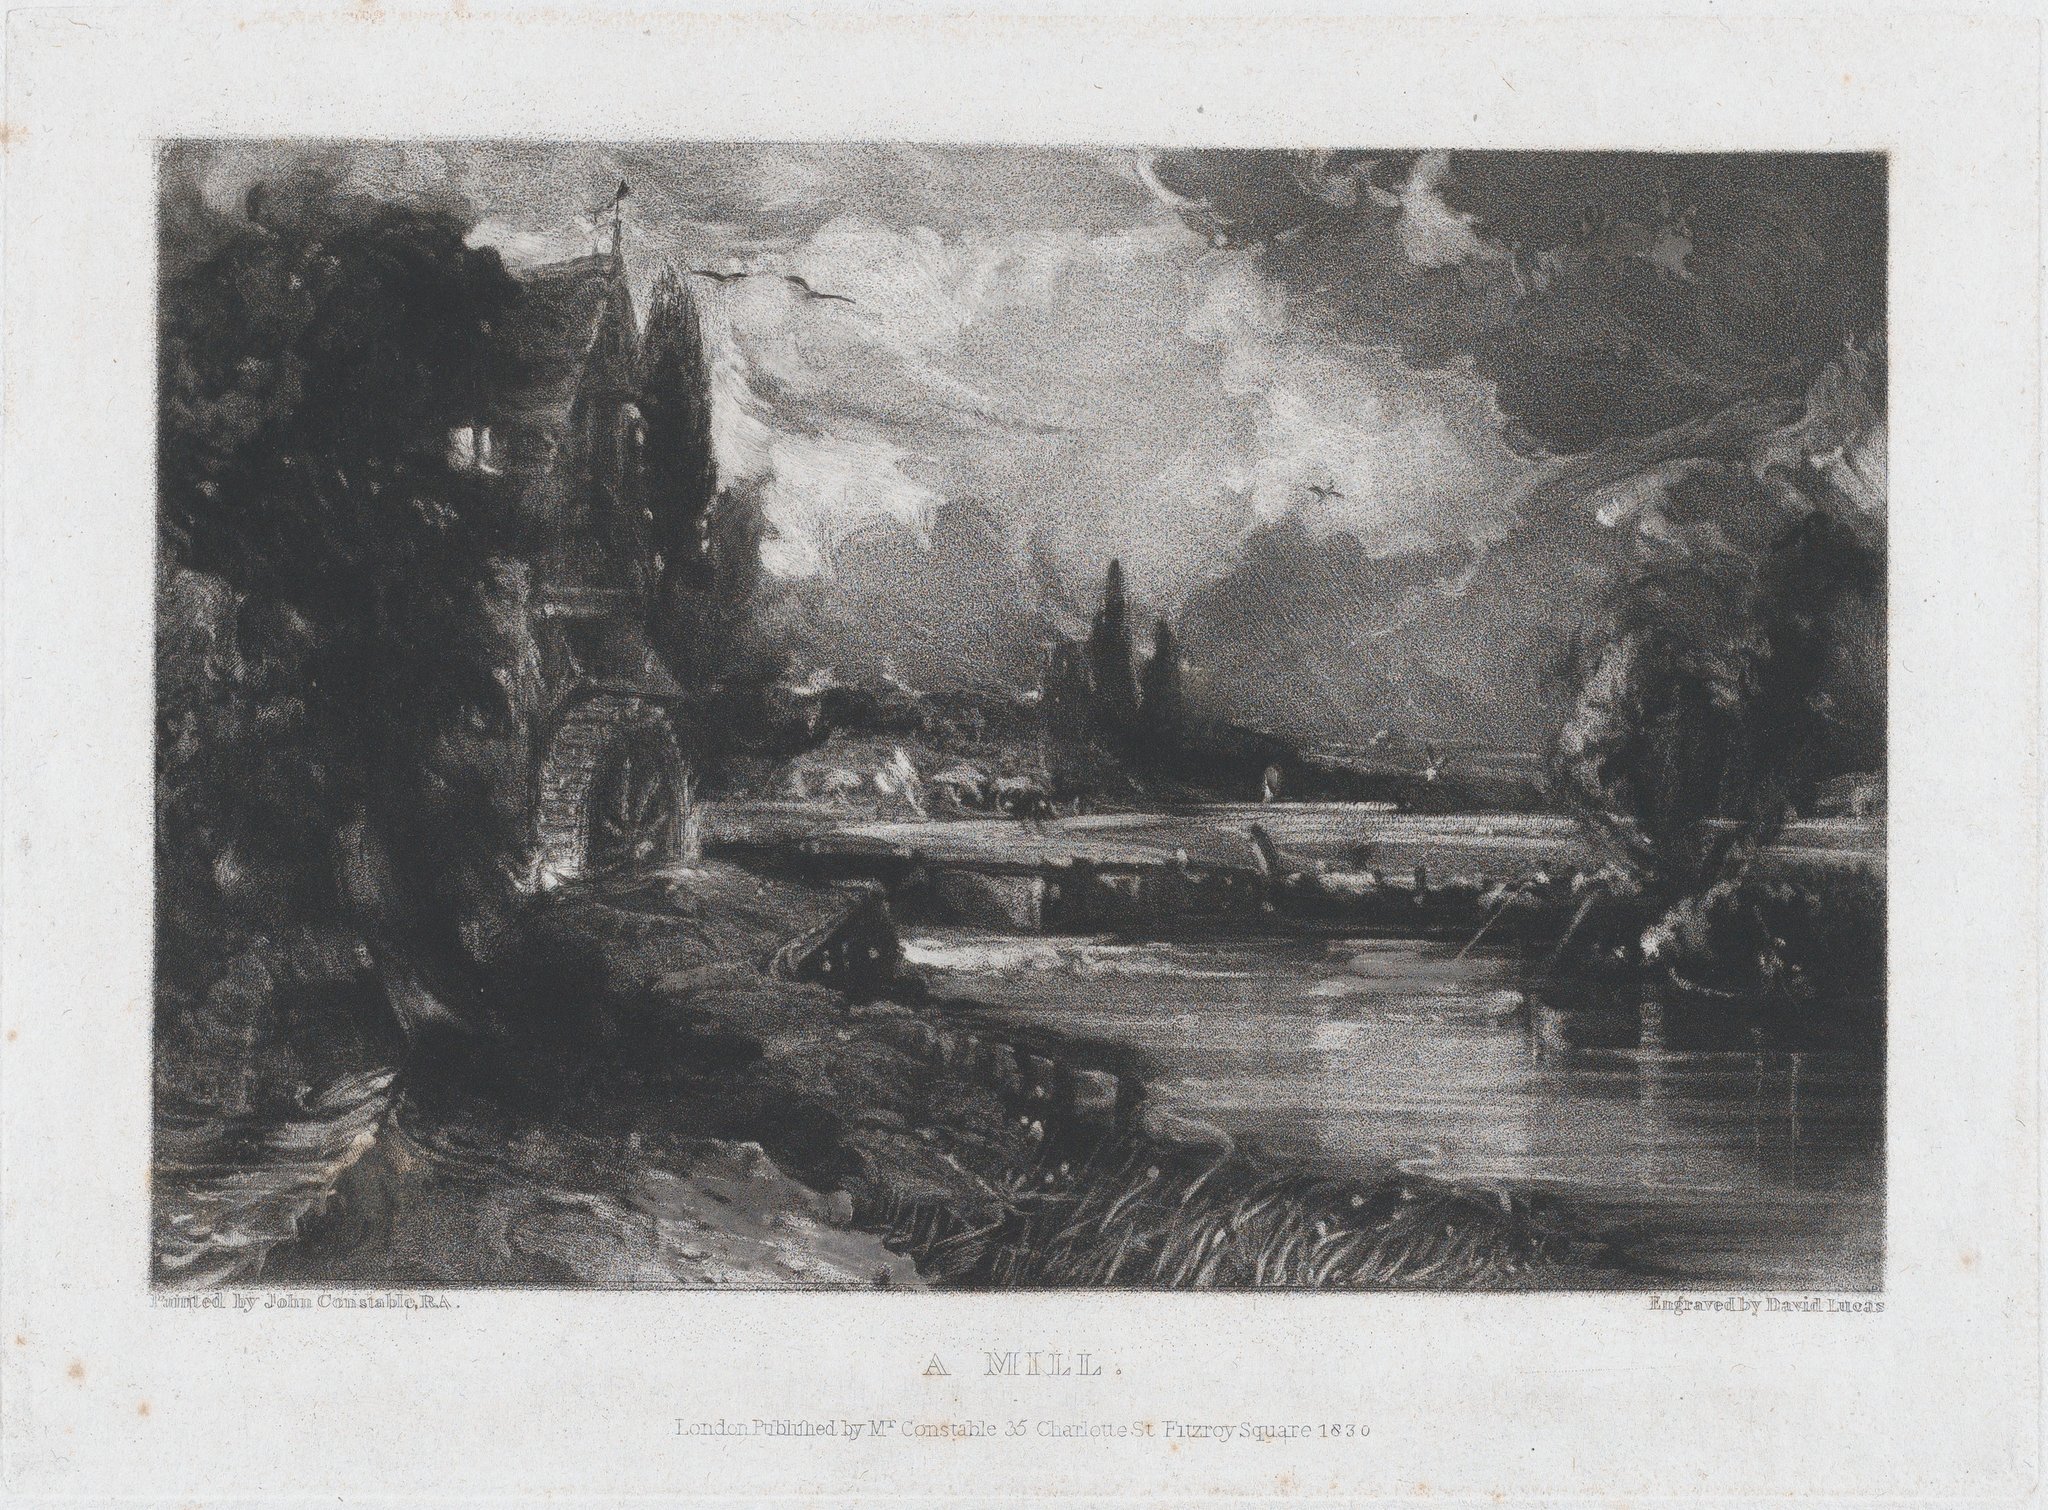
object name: print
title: A Mill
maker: david lucas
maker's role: artist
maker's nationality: british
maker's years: 1802-1881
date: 1830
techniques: mezzotint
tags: watermills,landscapes